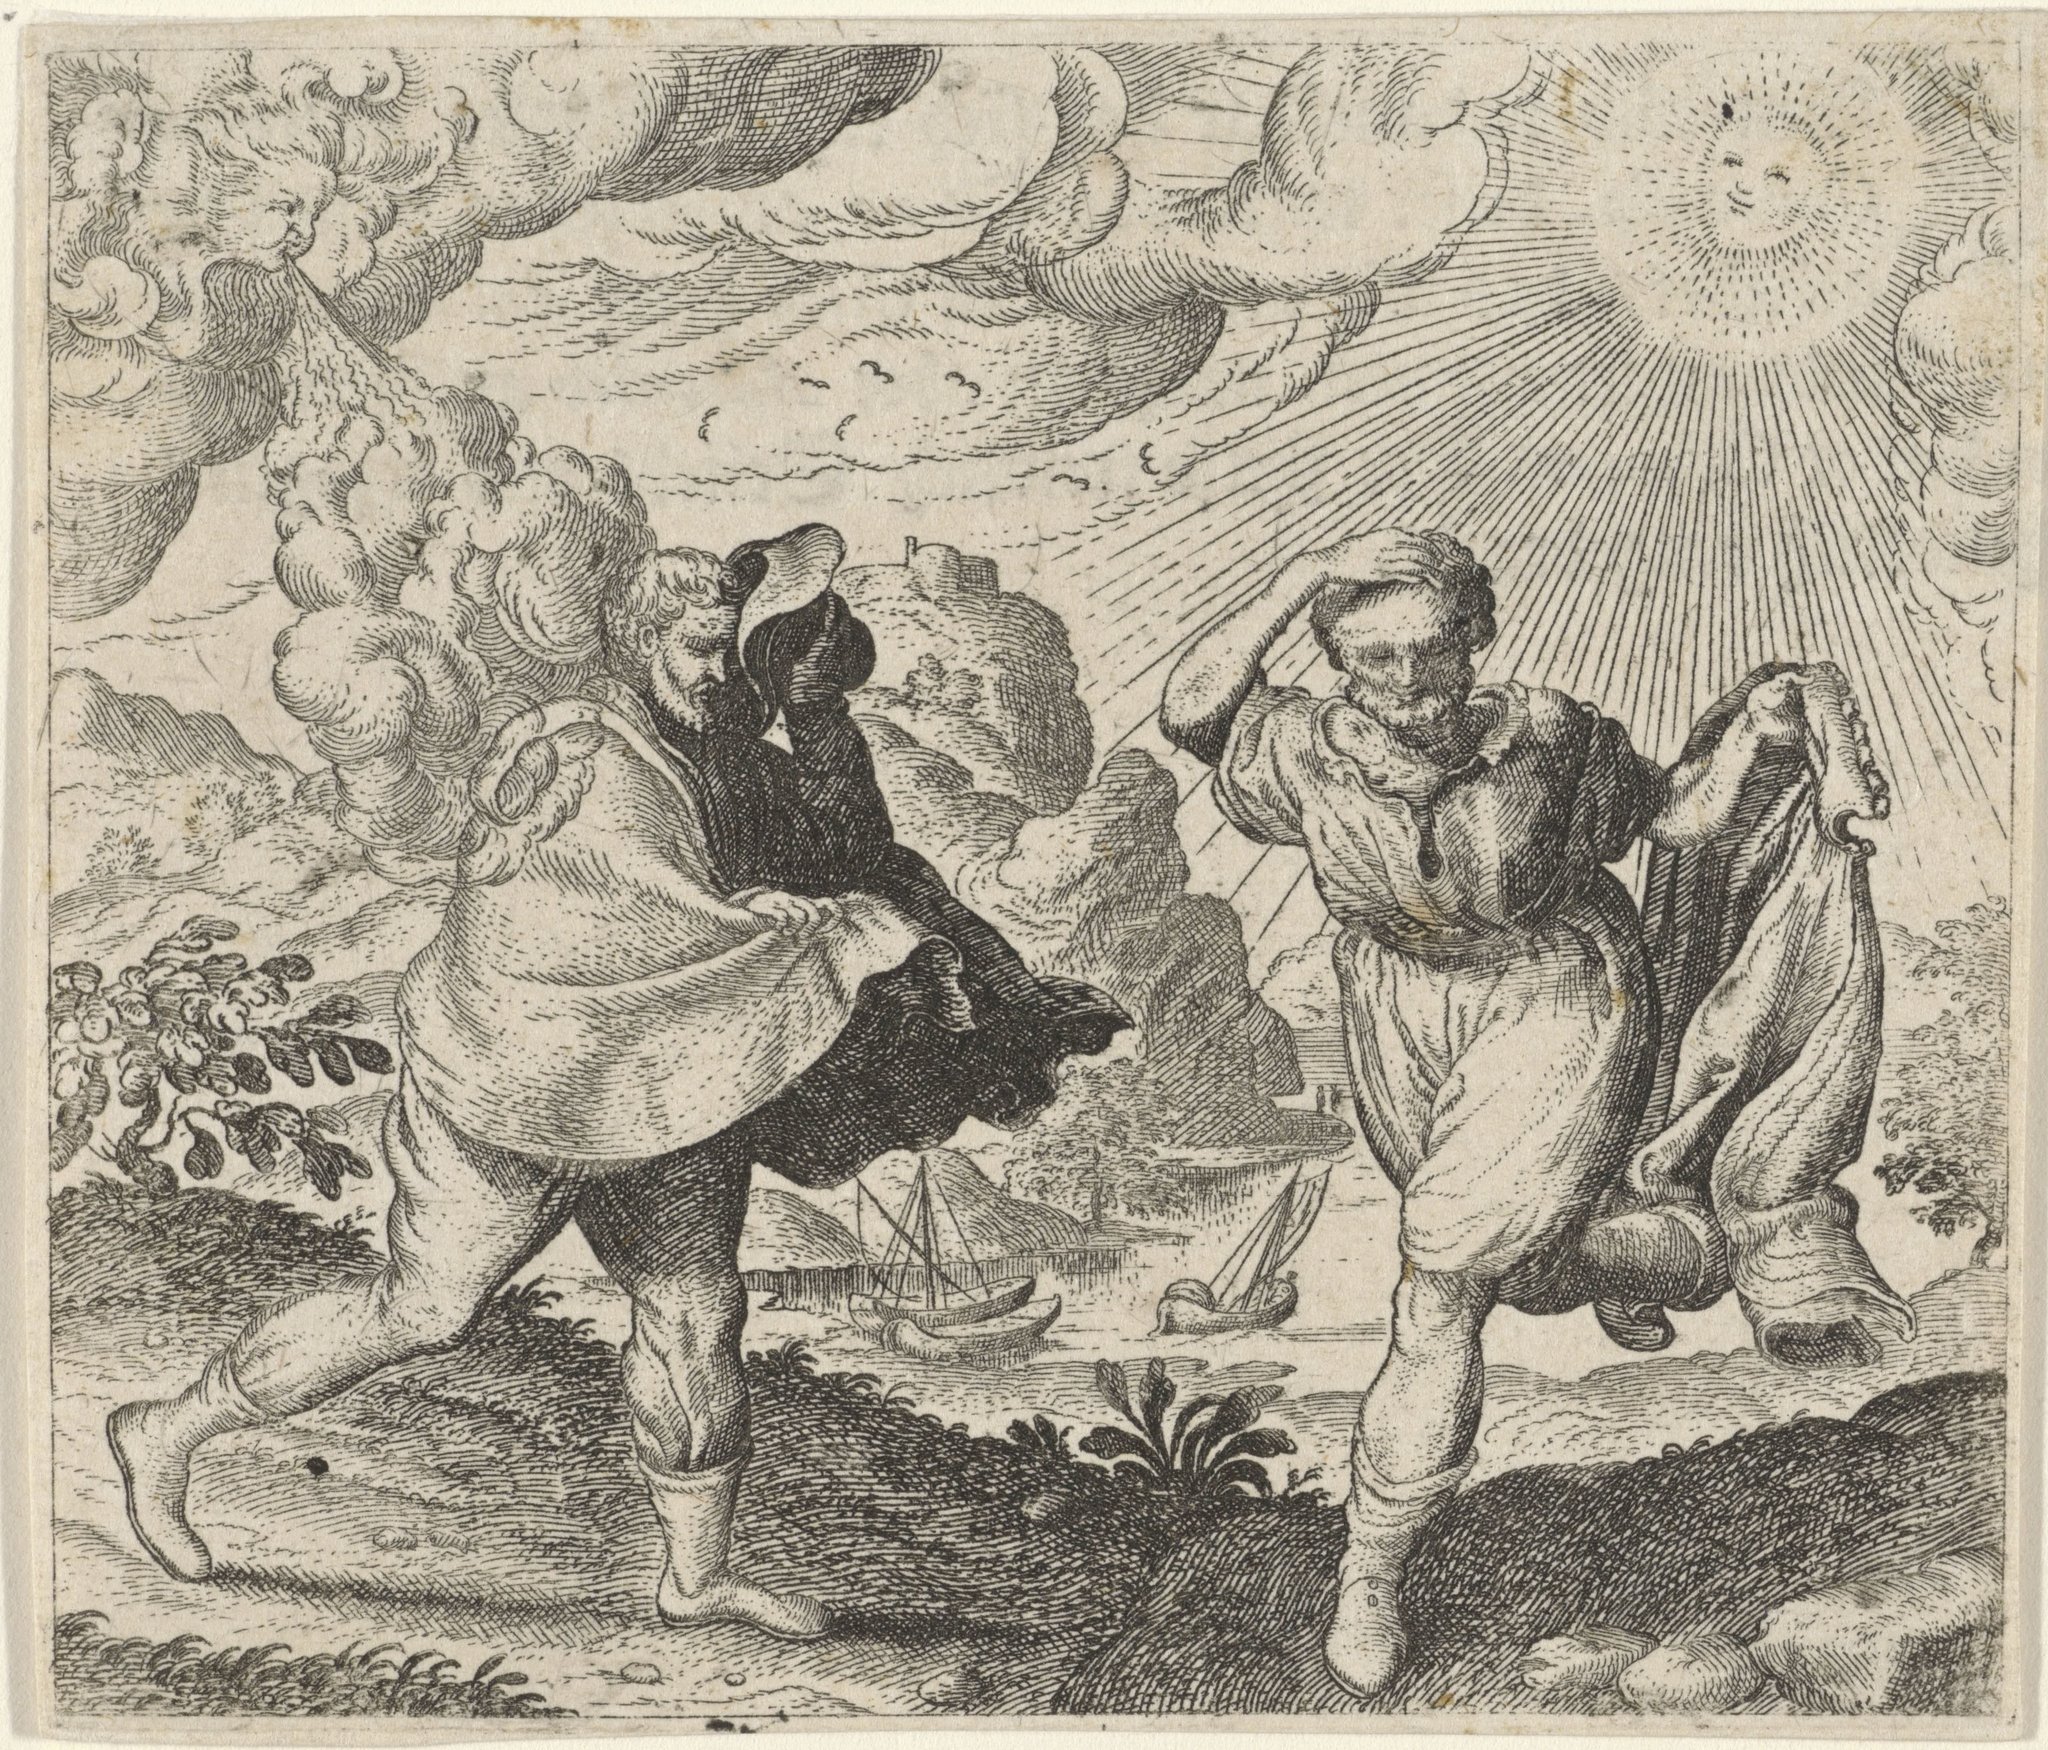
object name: print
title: Fabel van de wind, de zon en de wandelaars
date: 1608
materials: paper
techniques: engraving, etching, letterpress printing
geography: prague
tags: sun represented as face, wheel, etc., fables, 'en route', traveller under way, gods of the winds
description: De wind en de zon strijden wie het machtigste is. De koude wind zorgt ervoor dat een wandelaar zich warm kleed. De zon zorgt ervoor dat een wandelaar zijn mantel afwerpt. De moraal van het verhaal leert dat het volk liever met zachte hand wordt bestuurd.